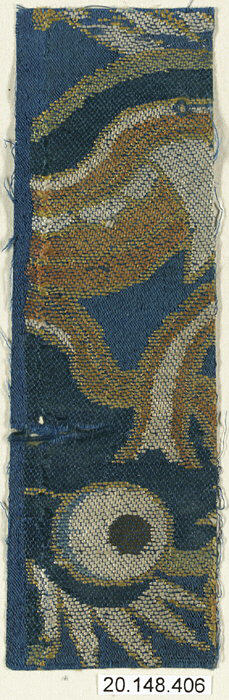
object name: piece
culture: japanese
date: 1801-1900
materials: silk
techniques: compound weave